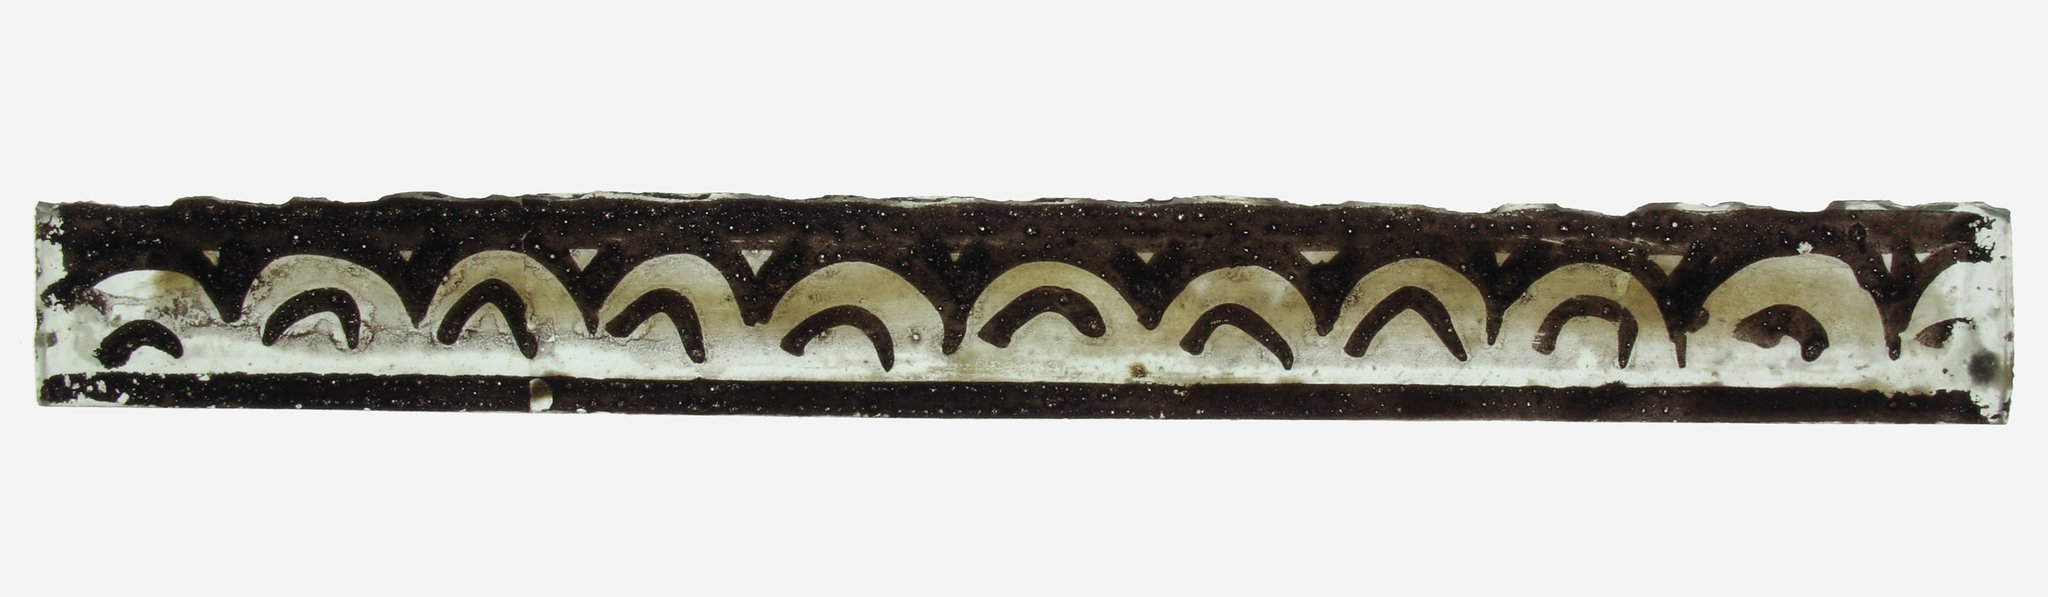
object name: fragment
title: Glass Fragment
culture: european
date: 1301-1500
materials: glass